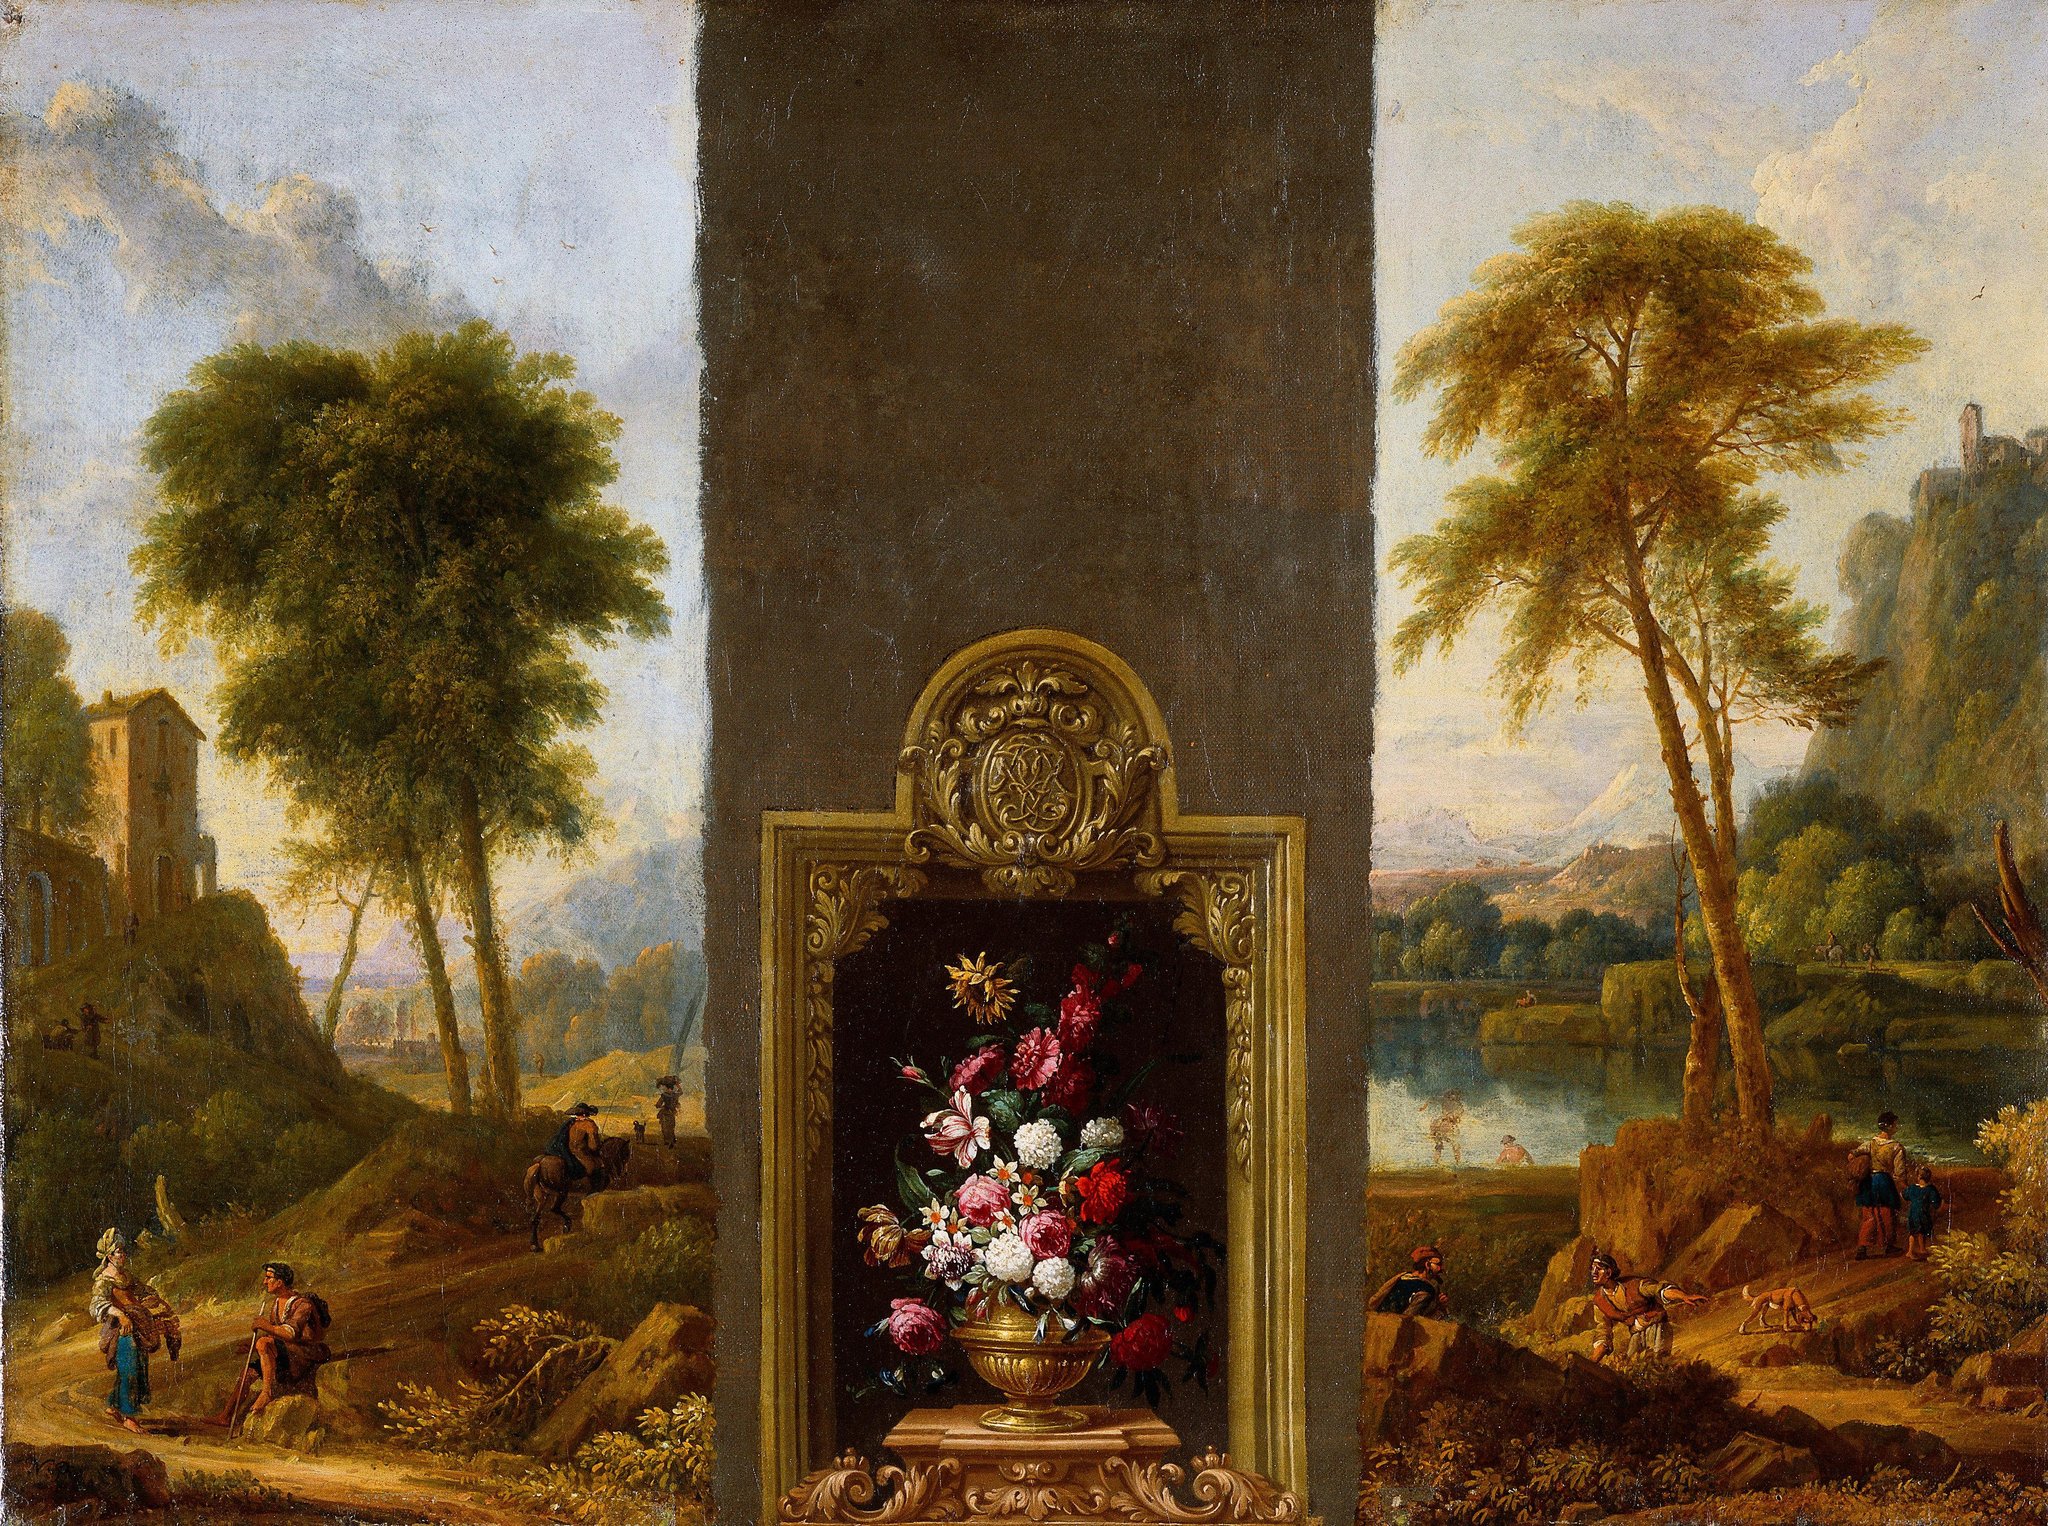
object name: miniature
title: Bloemstilleven in omlijsting met monogram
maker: willem hendrik wilhelmus van royen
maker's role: draughtsman, painter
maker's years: 1672-1742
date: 1690-1710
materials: canvas, oil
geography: amsterdam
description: Bloemstilleven, vast in de haard van een poppenhuis, bestaande uit een bloemstuk in een koperen vaas, staande op een roodbruine stenen sokkel en acanthusblad motieven. Het bloemstuk is als het ware geplaatst in een haard nis, omlijst door een geelgrijze stenen geprofileerde rand met bladmotieven en bekroond door een cartouche met een spiegelmonogram van letters EI (?) of BI.